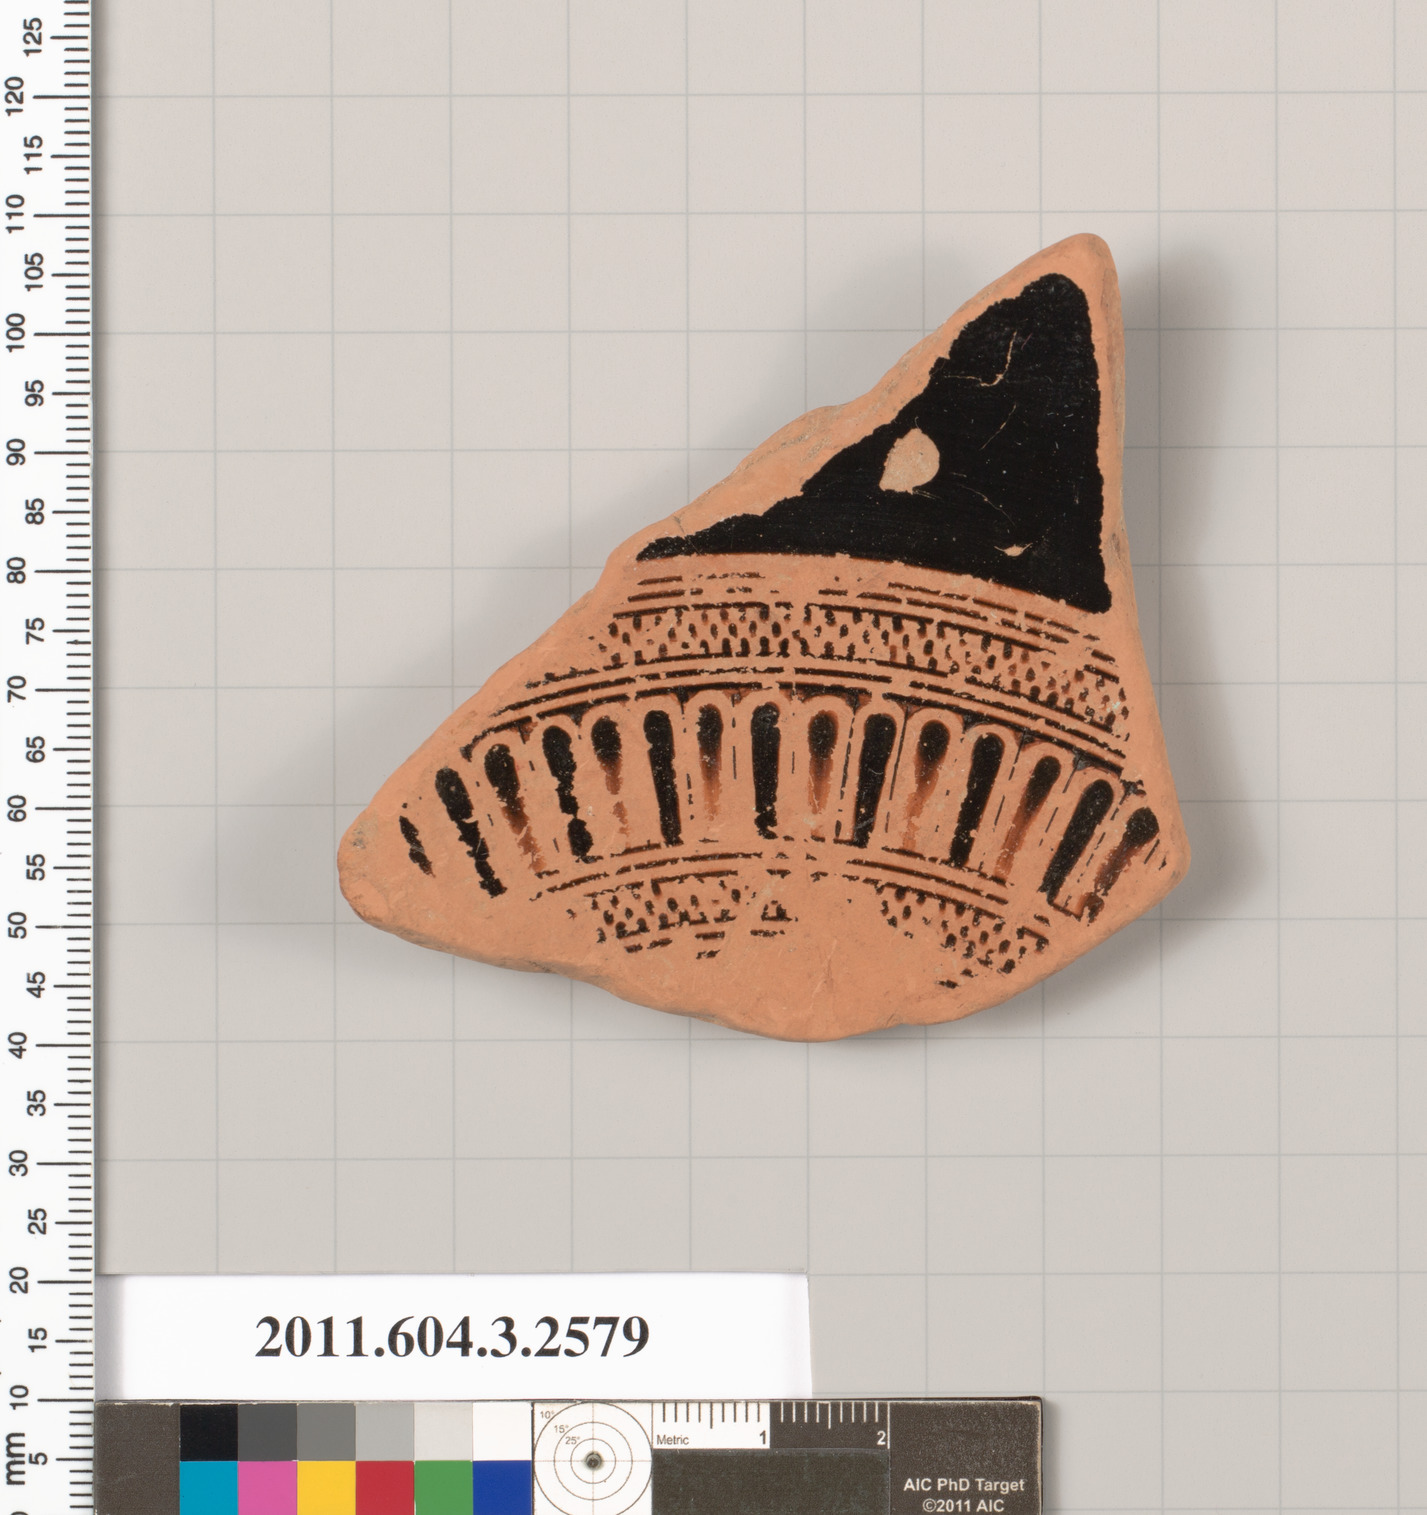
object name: kylix fragment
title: Terracotta fragment of a Little Master cup (drinking cup)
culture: greek, attic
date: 575-551 BCE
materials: terracotta